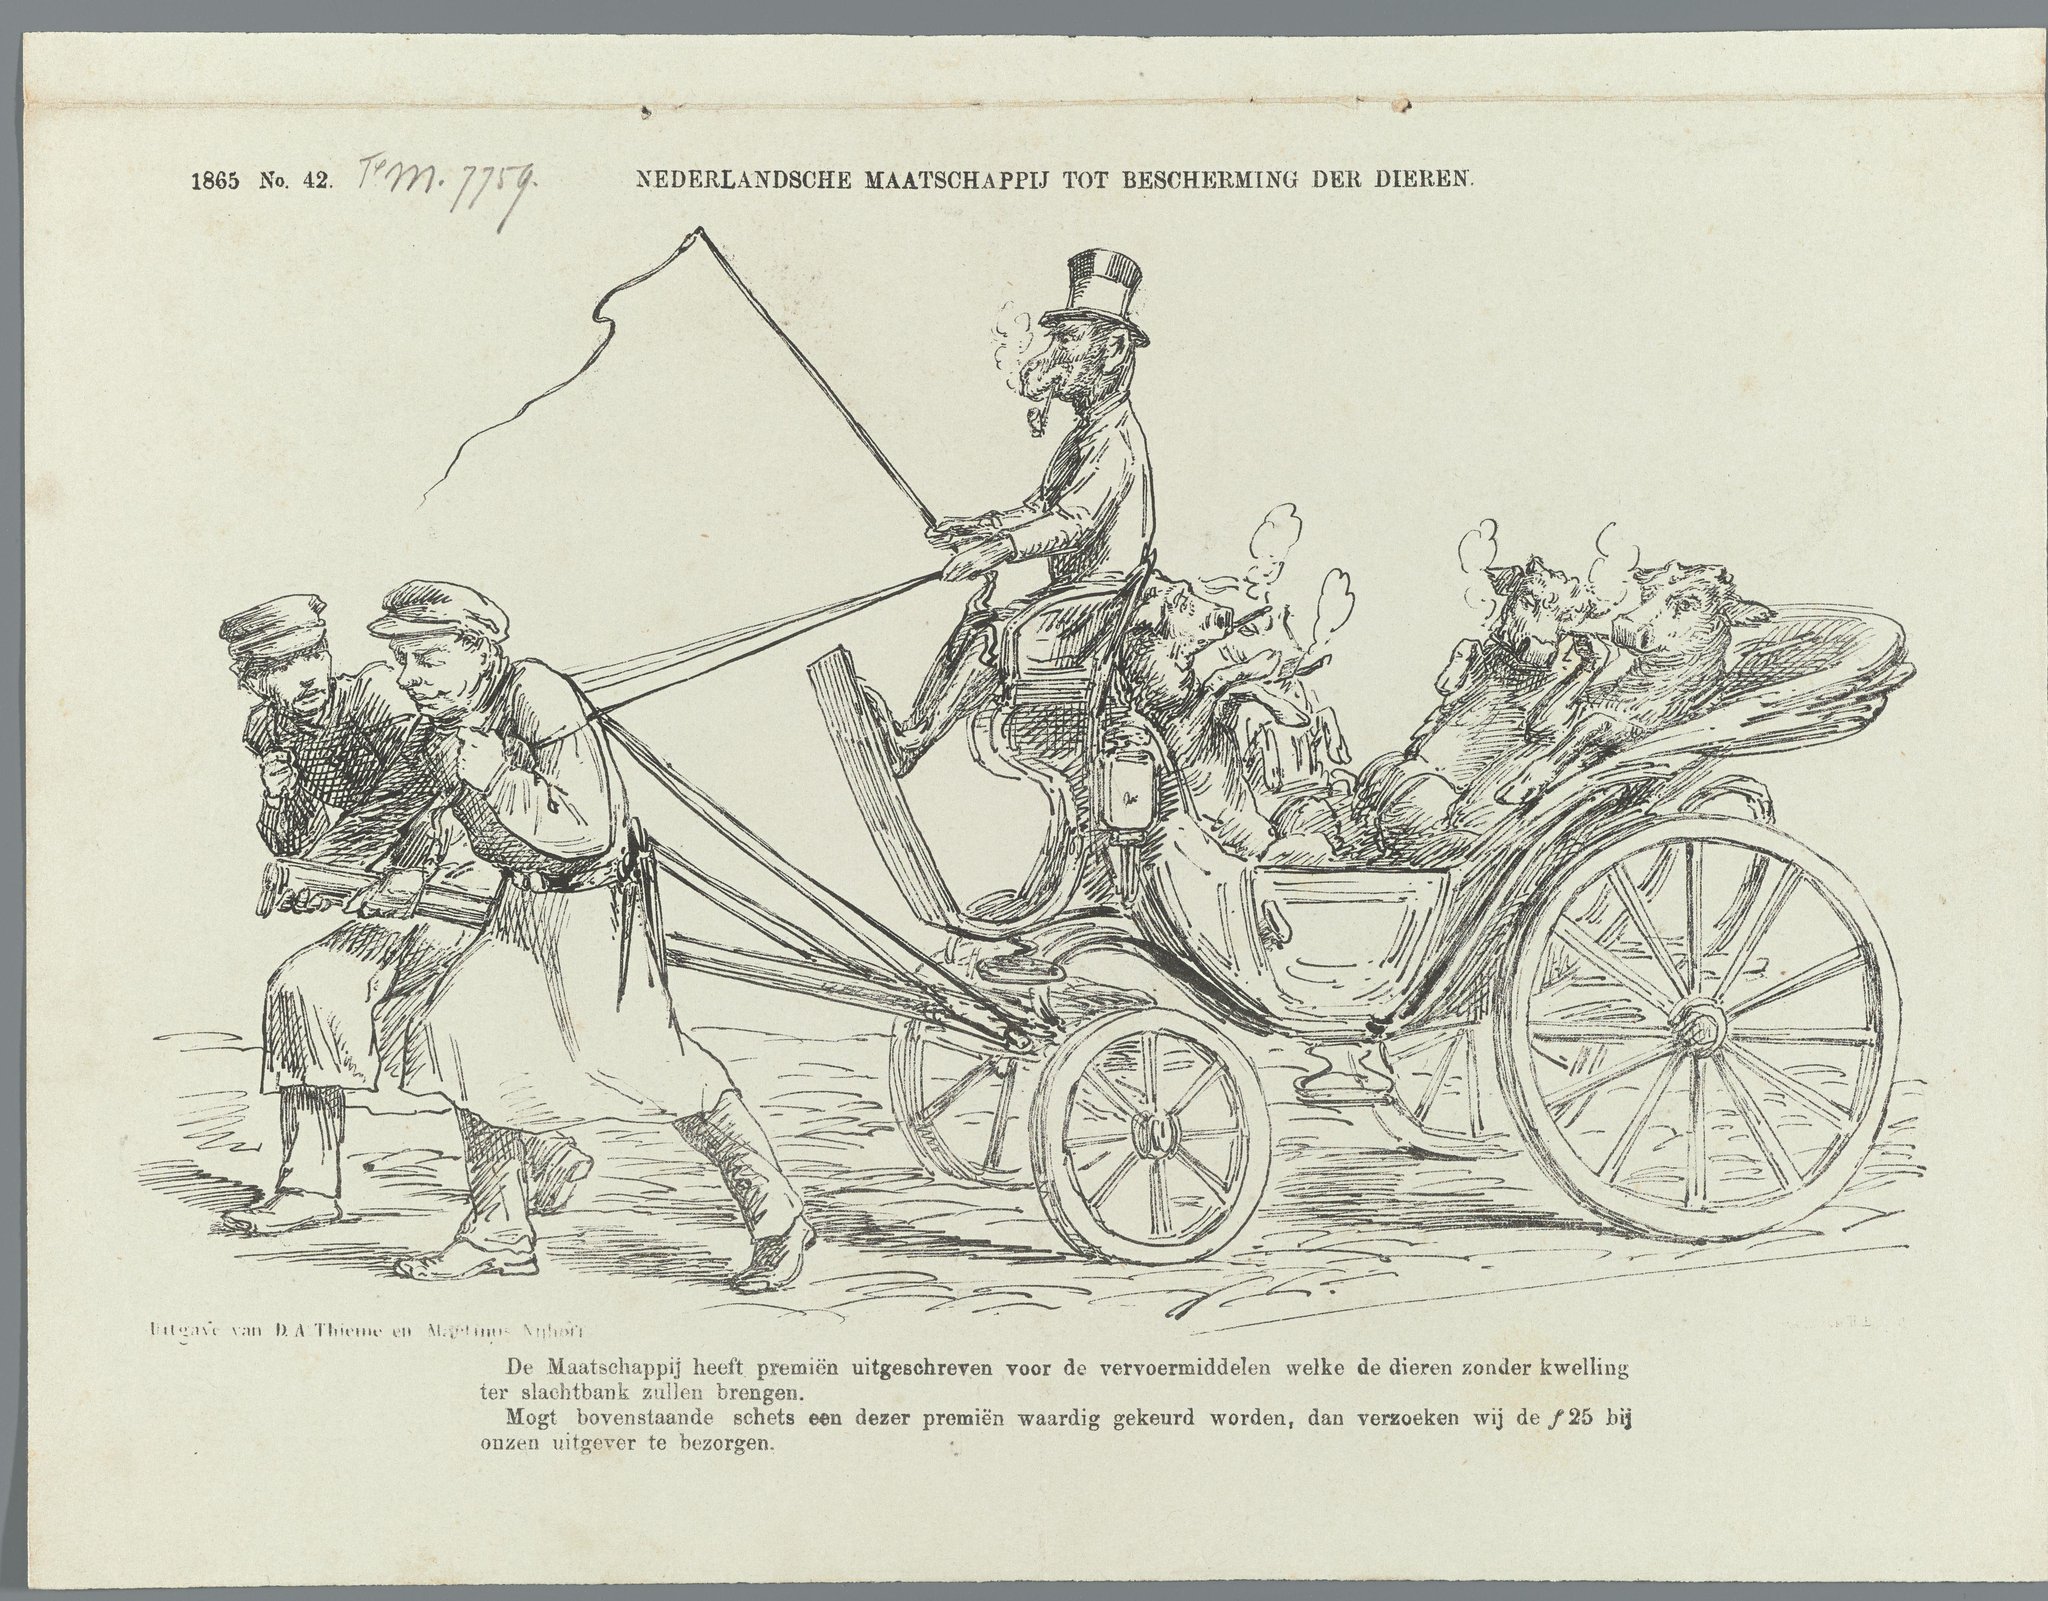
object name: cartoon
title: Spotprent op de Nederlandsche Maatschappij tot Bescherming der Dieren, 1865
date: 1865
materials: paper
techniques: lithograph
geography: netherlands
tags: animals acting as human beings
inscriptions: collector's mark: Lugt 2228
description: Spotprent op de premie uitgeloofd door de Nederlandsche Maatschappij tot Bescherming der Dieren aan bedrijven die de dieren zonder kwelling naar de slachtbanken brengen. Twee mannen trekken een rijtuig gemend door een aap en waarin dieren zitten en sigaren roken. Plaat verschenen bij het weekblad De Nederlandsche Spectator, nr. 42, 21 oktober 1865.